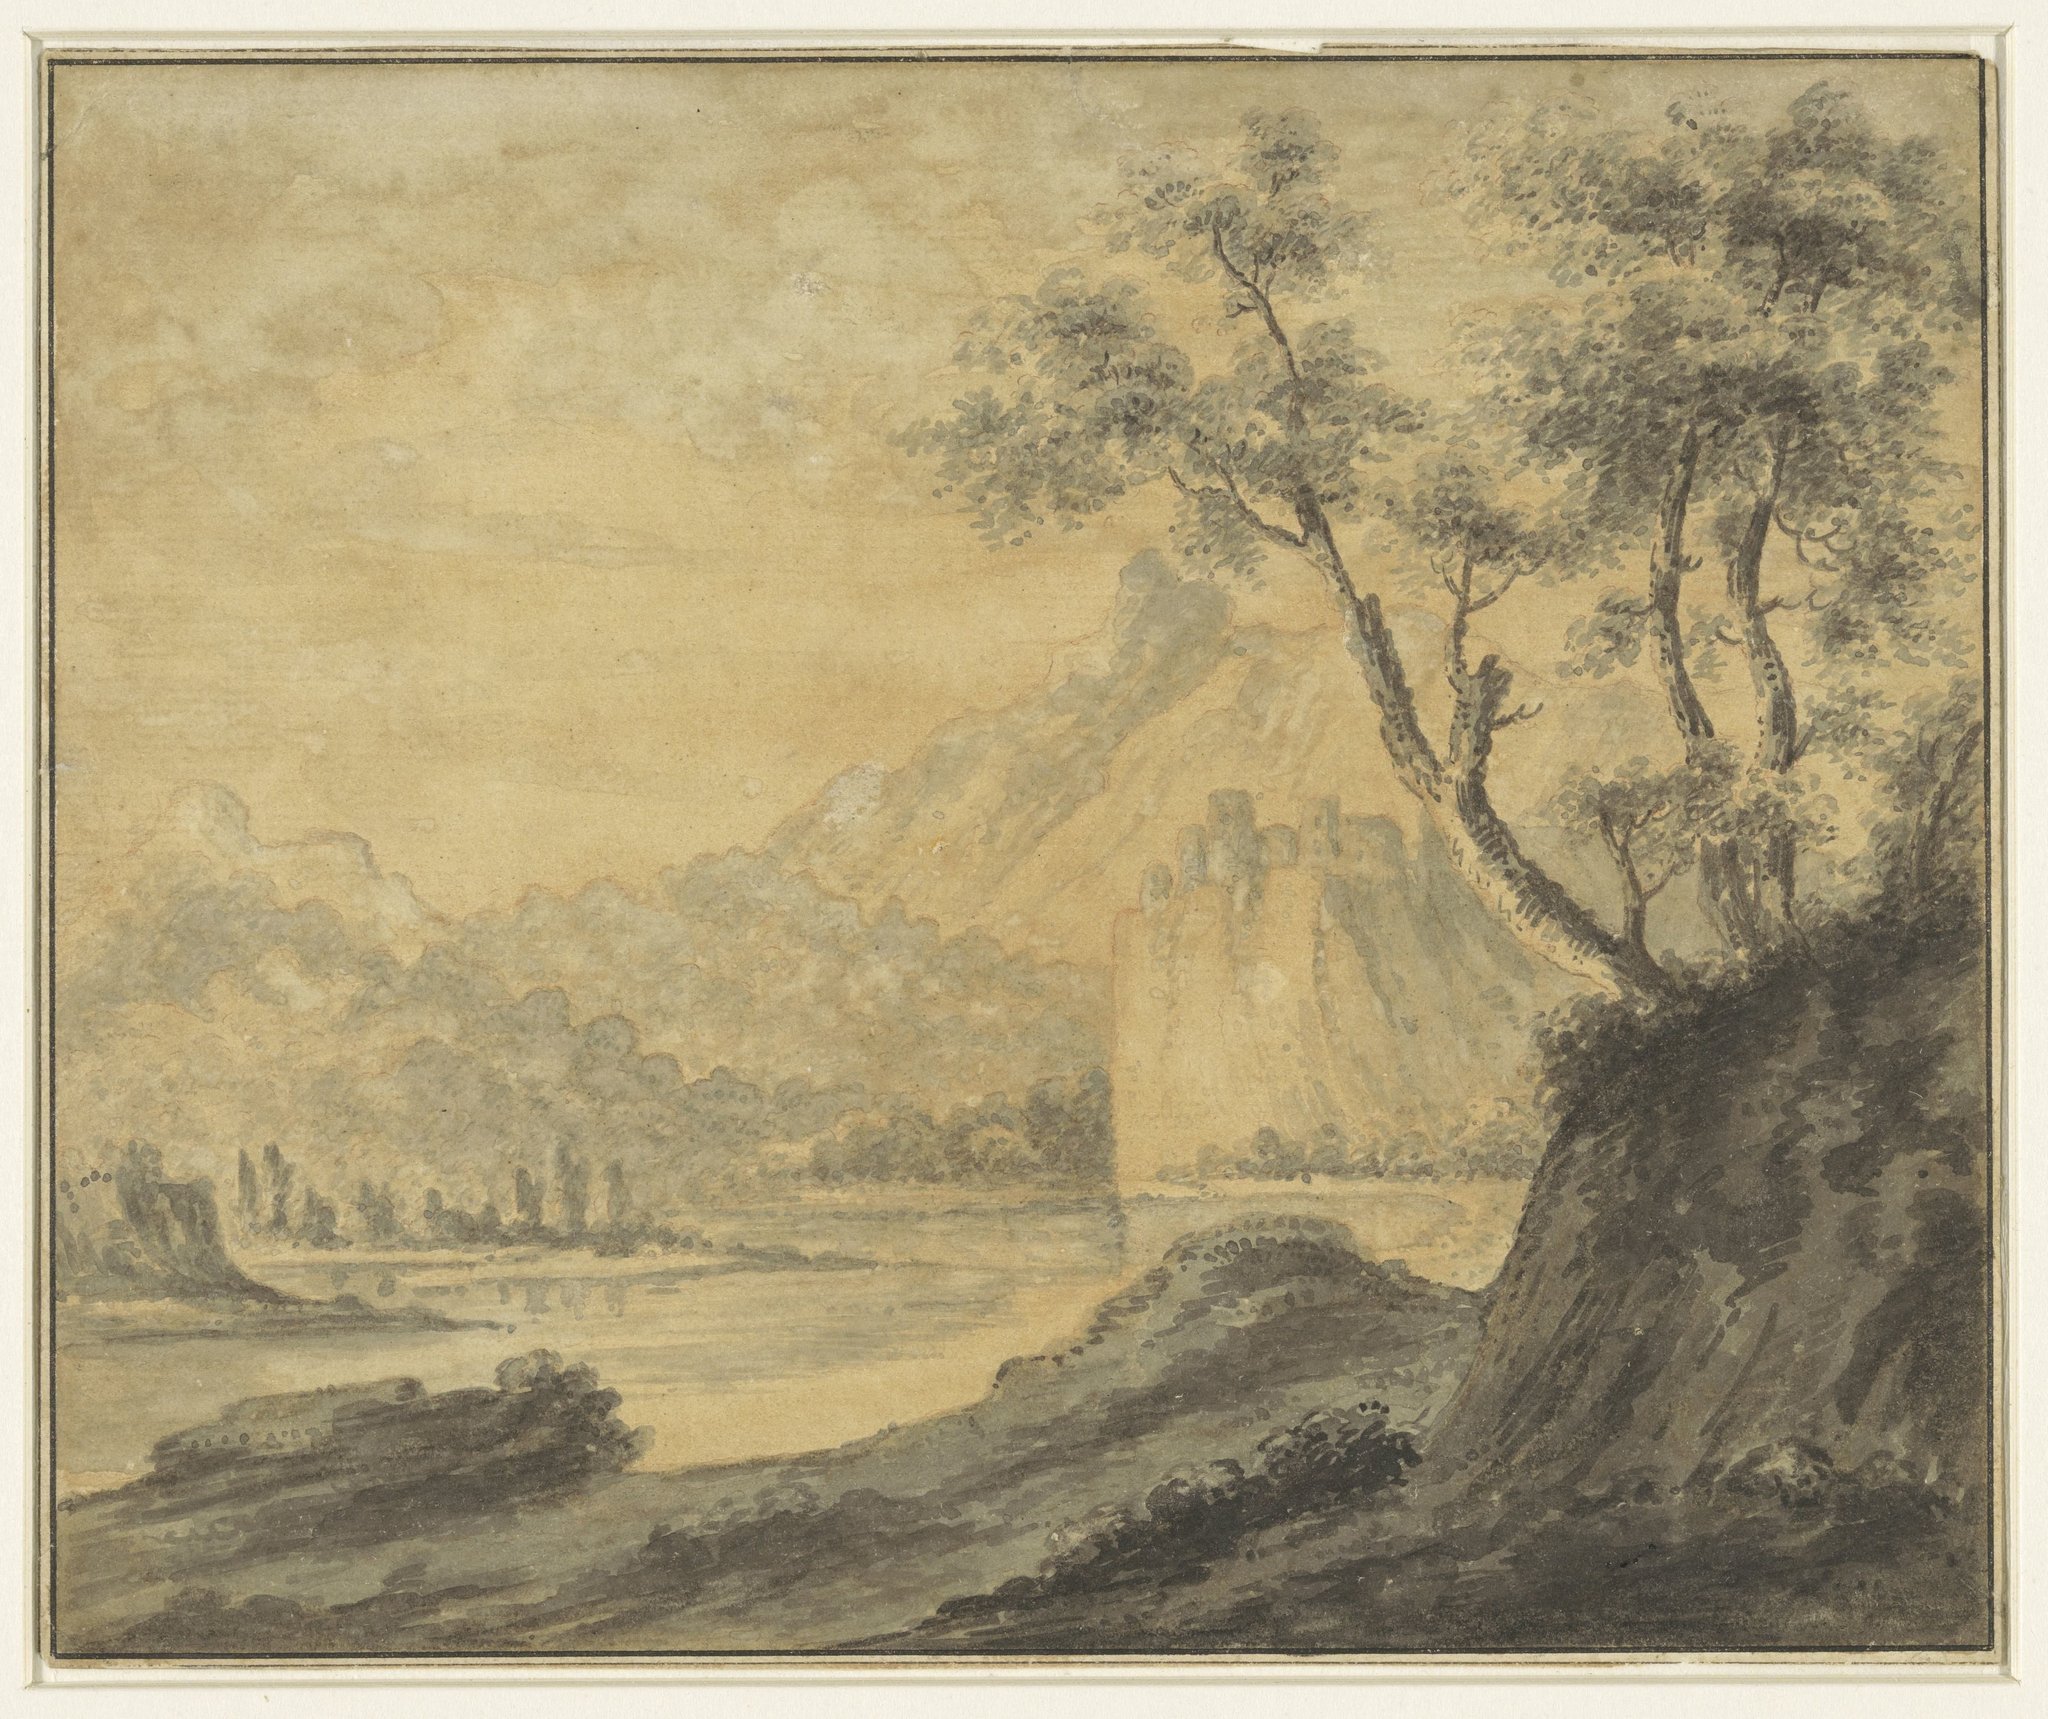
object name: drawing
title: Rivierlandschap met rotsen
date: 1775-1820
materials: chalk, ink, paper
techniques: brush, pen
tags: river